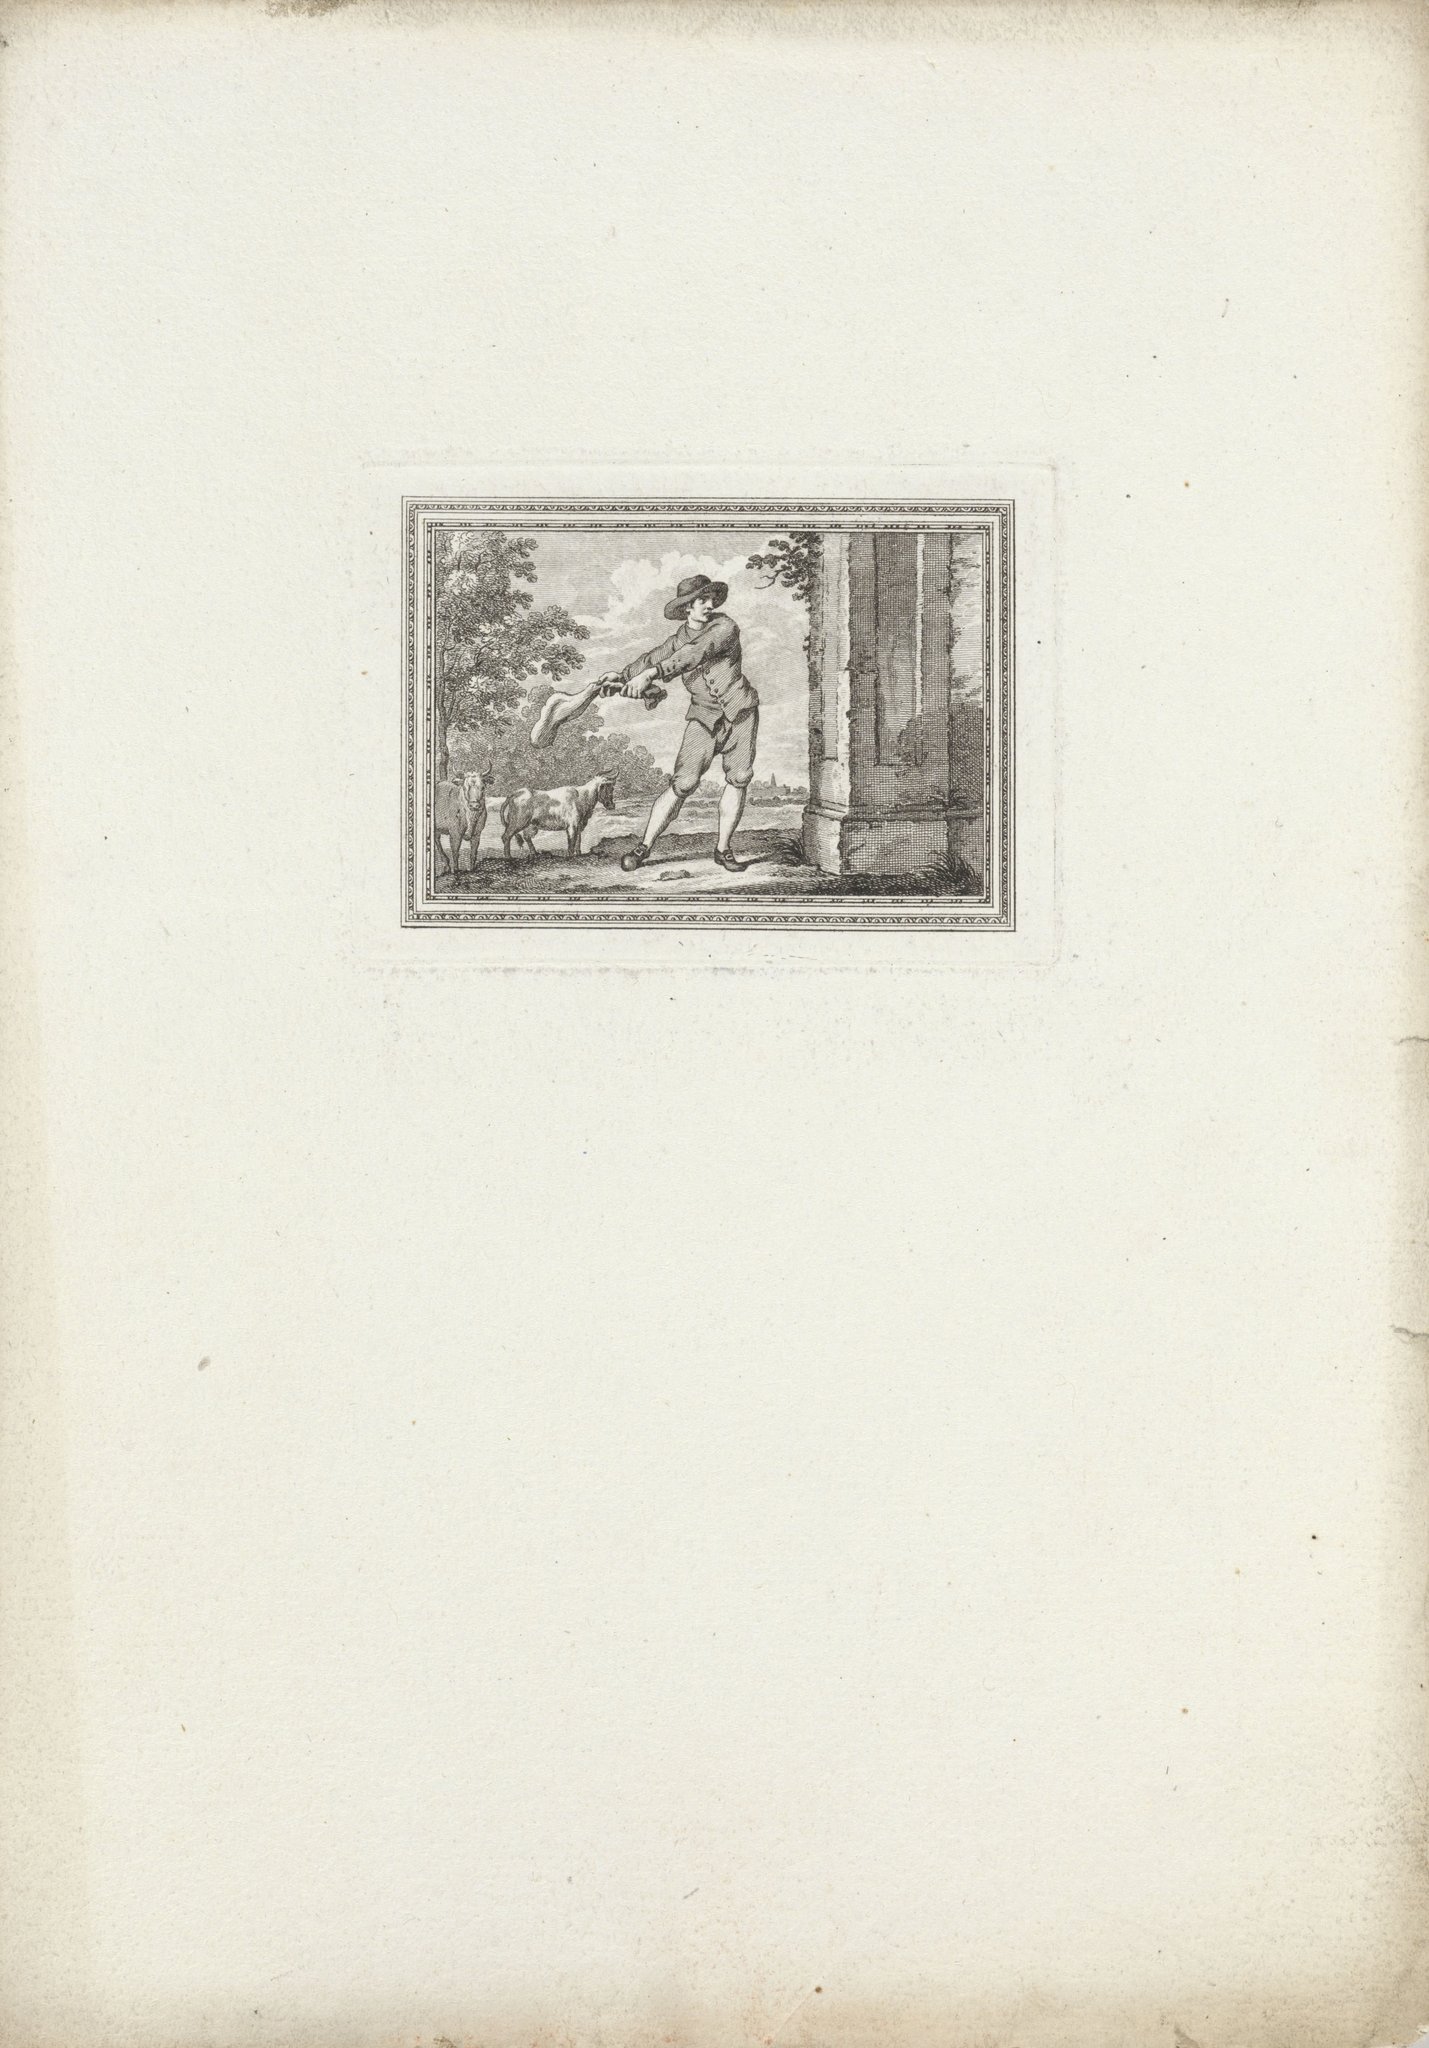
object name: print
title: De man en de adder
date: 1792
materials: paper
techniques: etching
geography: amsterdam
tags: snakes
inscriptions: collector's mark: Lugt 2228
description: Een man staat op het punt om een zak met een adder tegen een muur te slaan. Illustratie bij het verhaal 'De man en de adder' uit 'Fabelen voor de Nederlandsche jeugd'.